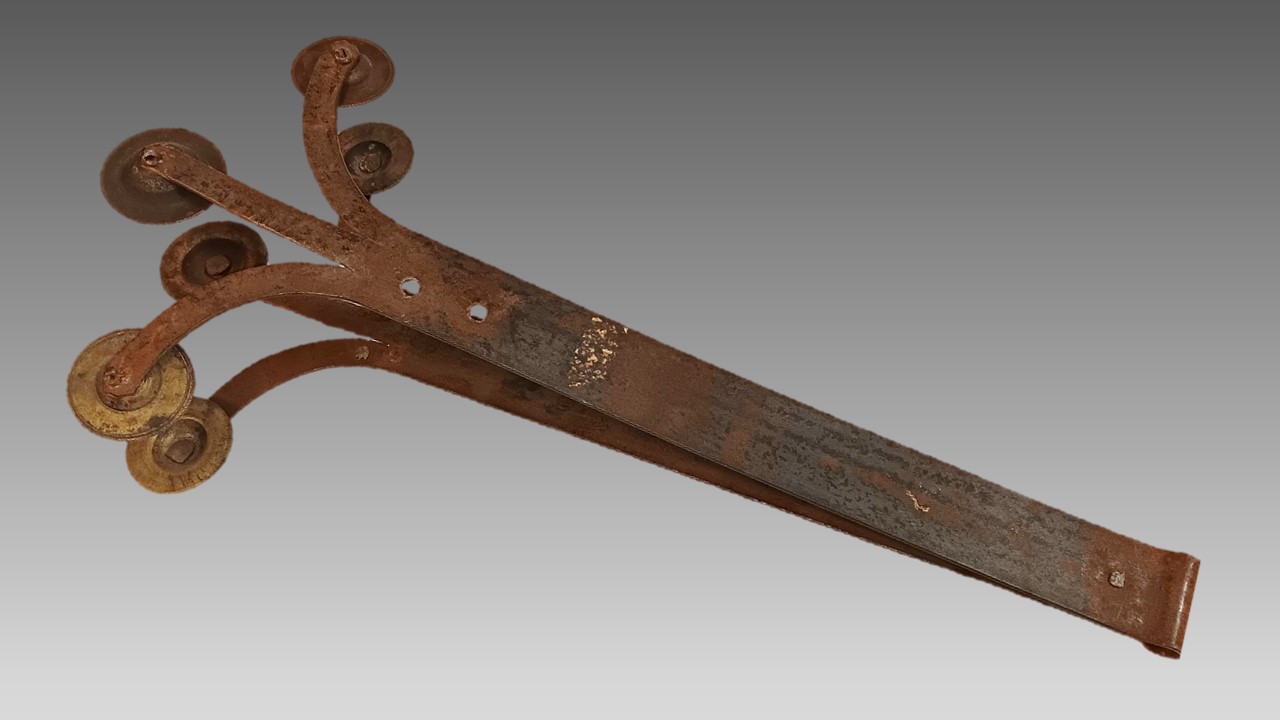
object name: zilli mașa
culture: turkish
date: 1867-1900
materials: brass, iron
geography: turkey